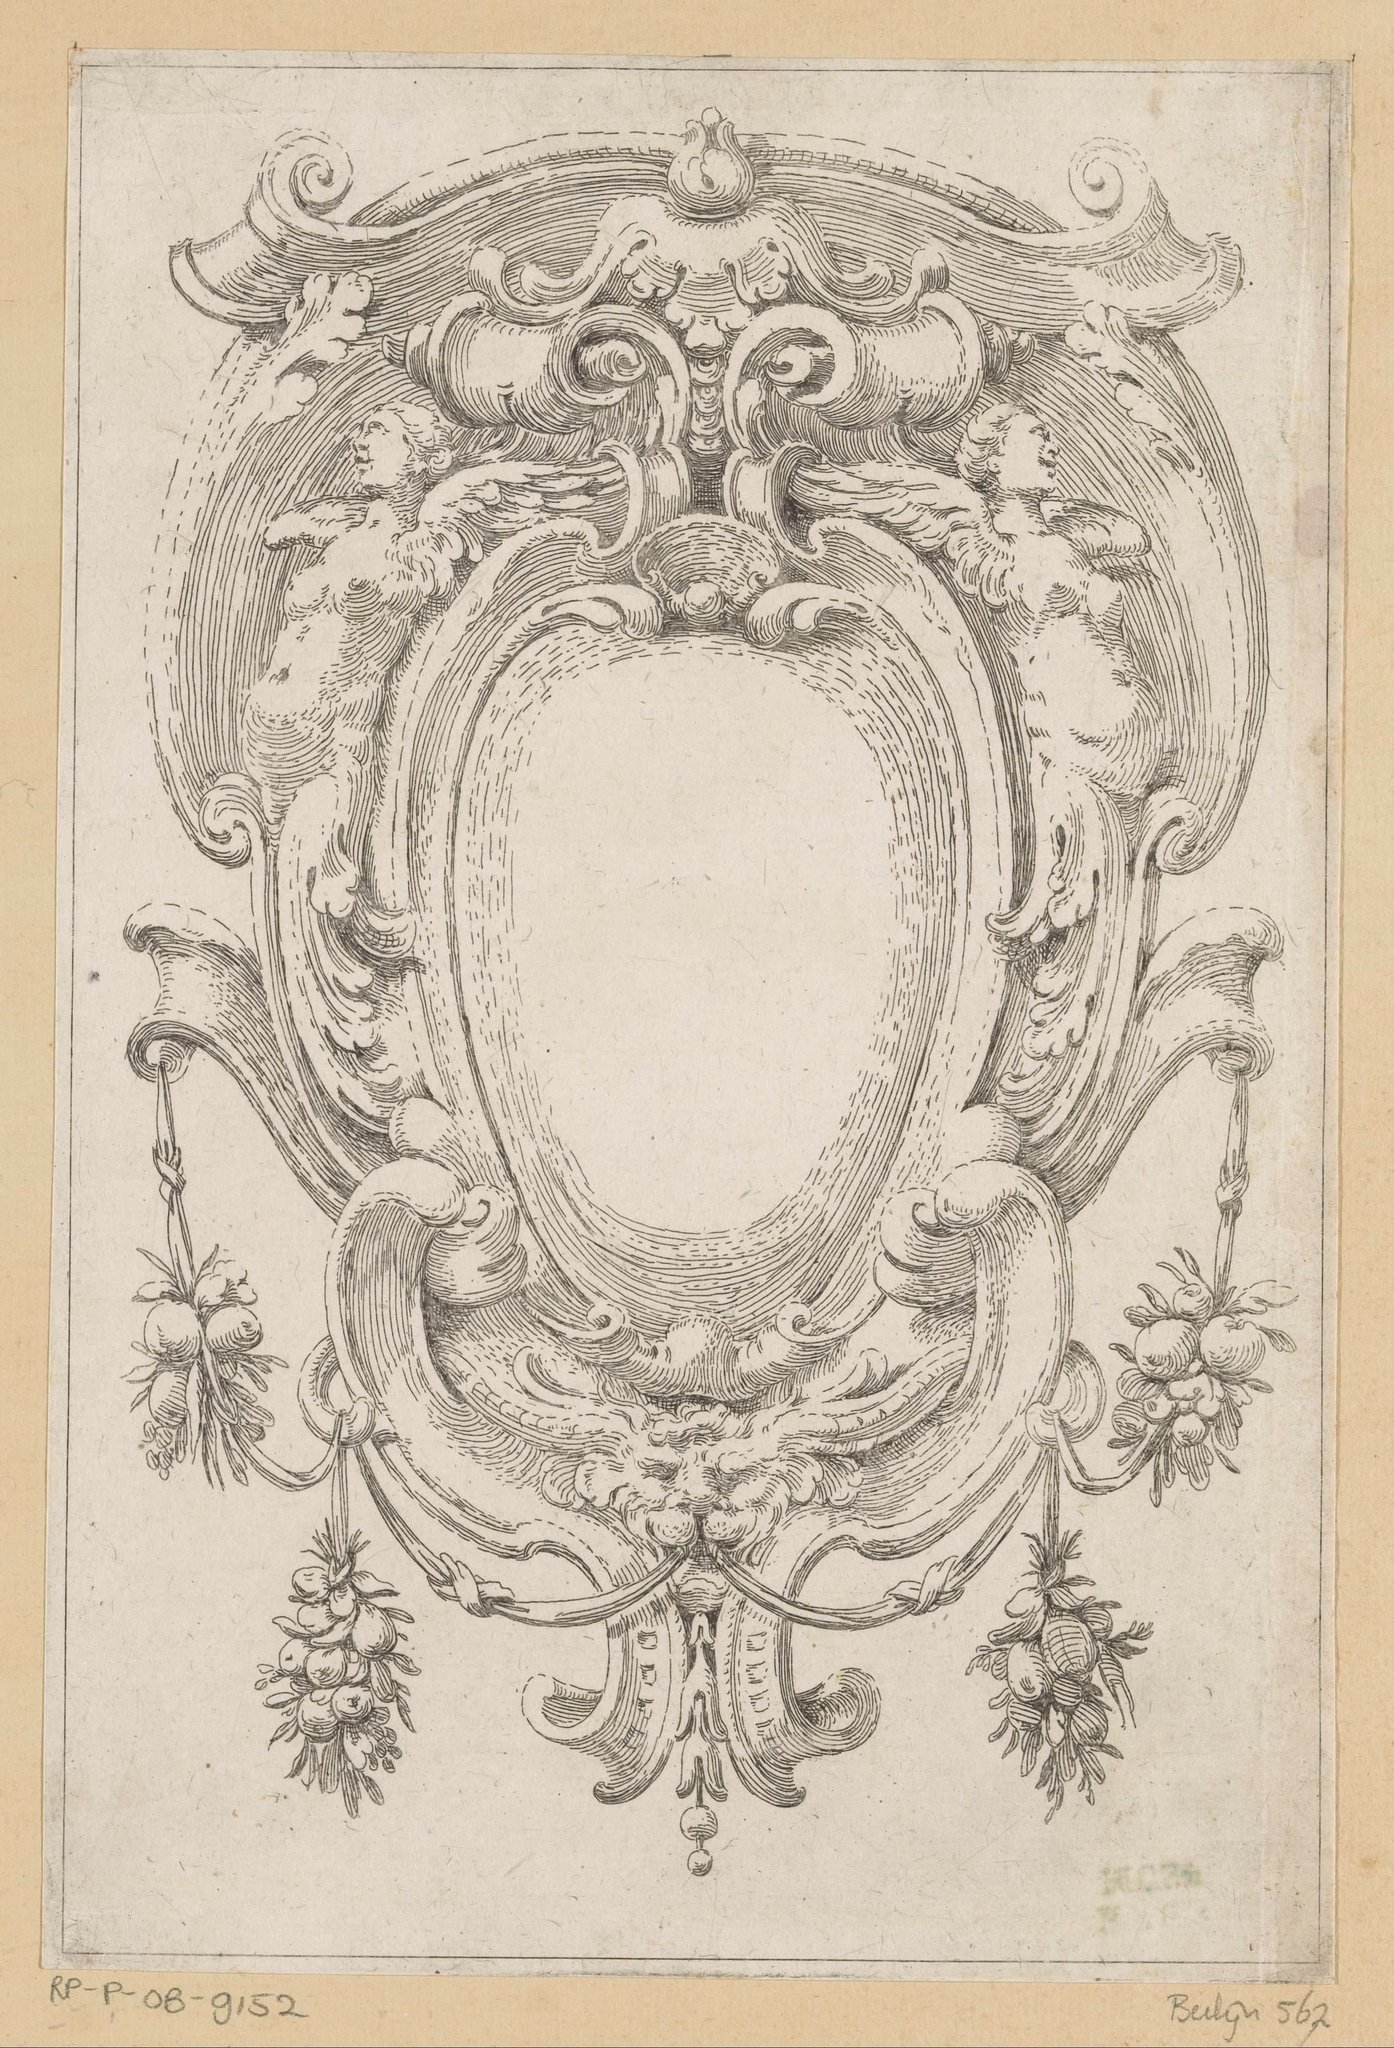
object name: ornament print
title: Cartouches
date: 1636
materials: paper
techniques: etching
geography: bologna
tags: ornament ~ cartouche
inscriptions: collector's mark: Lugt 2165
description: Deze prent maakt deel uit van een reeks van 22 prenten met in totaal 24 cartouches, plus een titelprent.